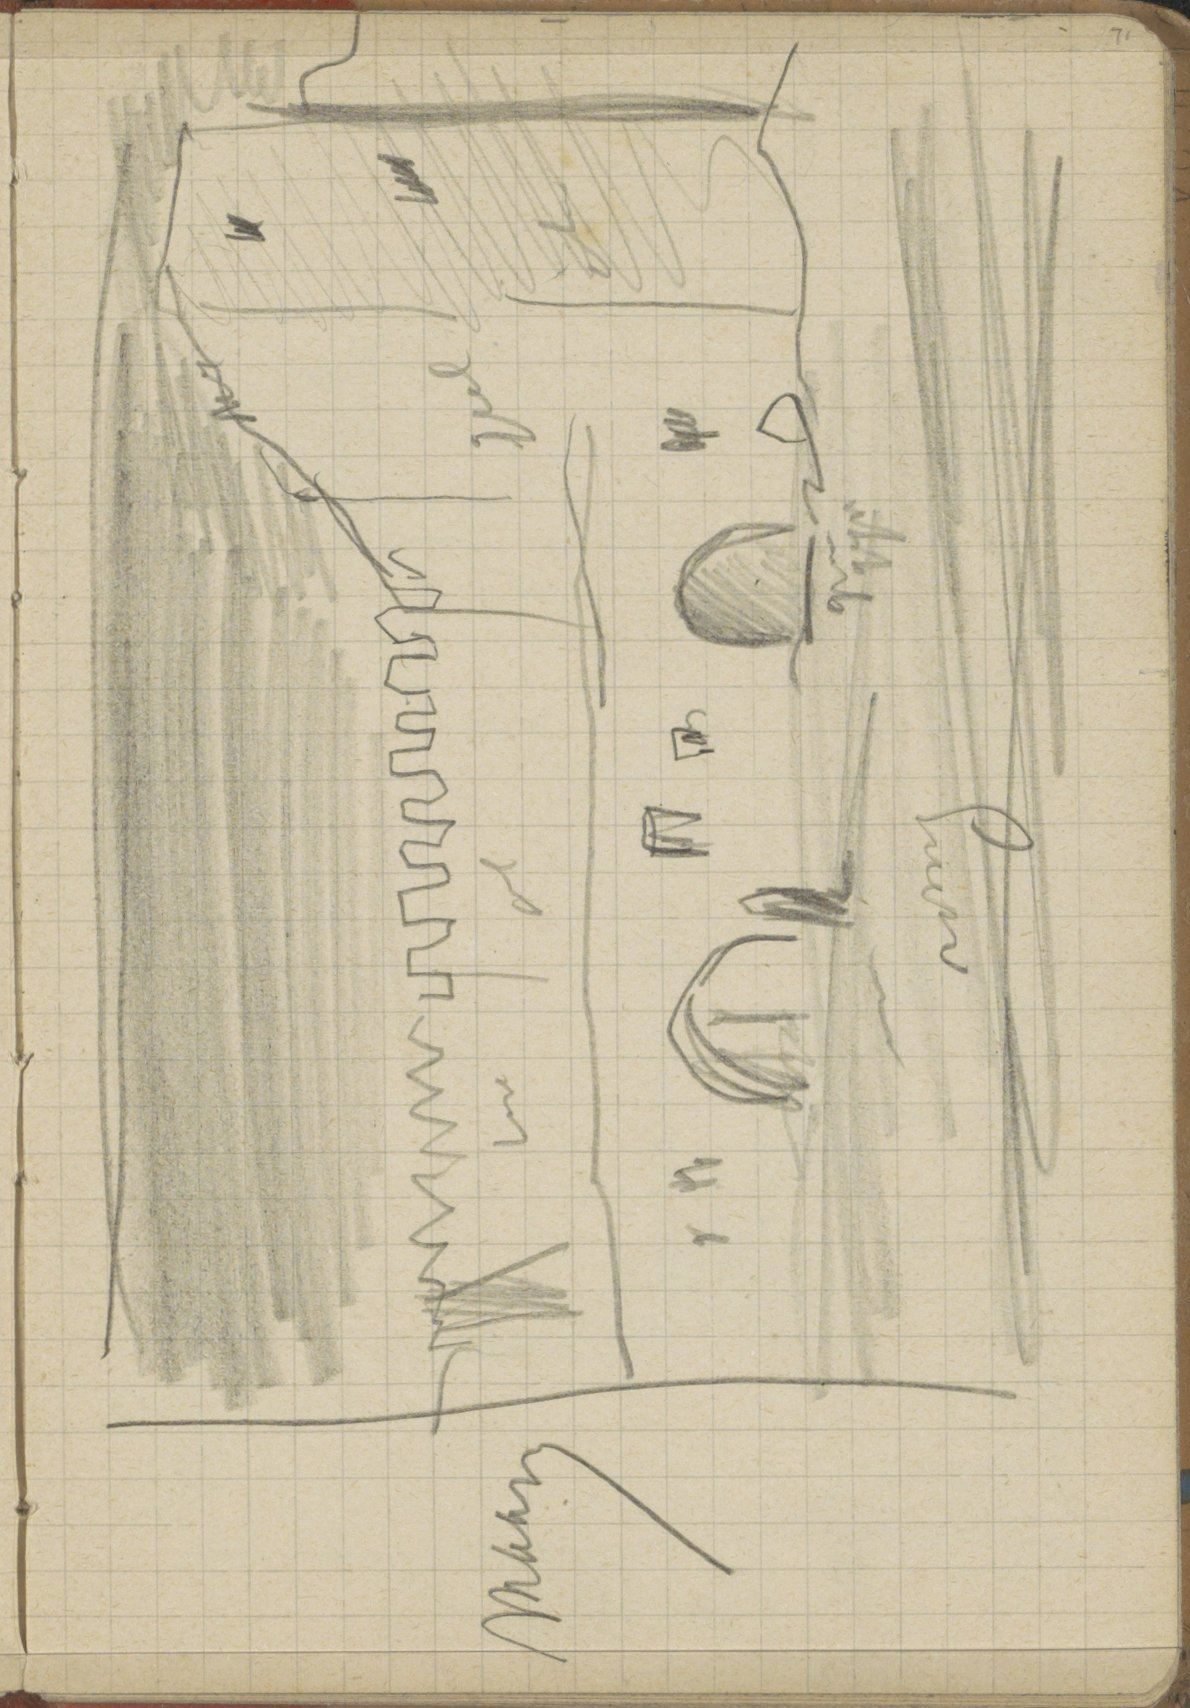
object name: sketchbook leaf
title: Binnenplaats van een gebouw met kantelen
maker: marius bauer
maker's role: draughtsman, print maker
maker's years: 1867-1932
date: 1909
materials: pencil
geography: tunisia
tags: courtyard, battlement, crenellation ~ fortified city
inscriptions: annotation: ‘maan’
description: Mogelijk een moskee. Pagina 71 uit een schetsboek met 67 bladen.